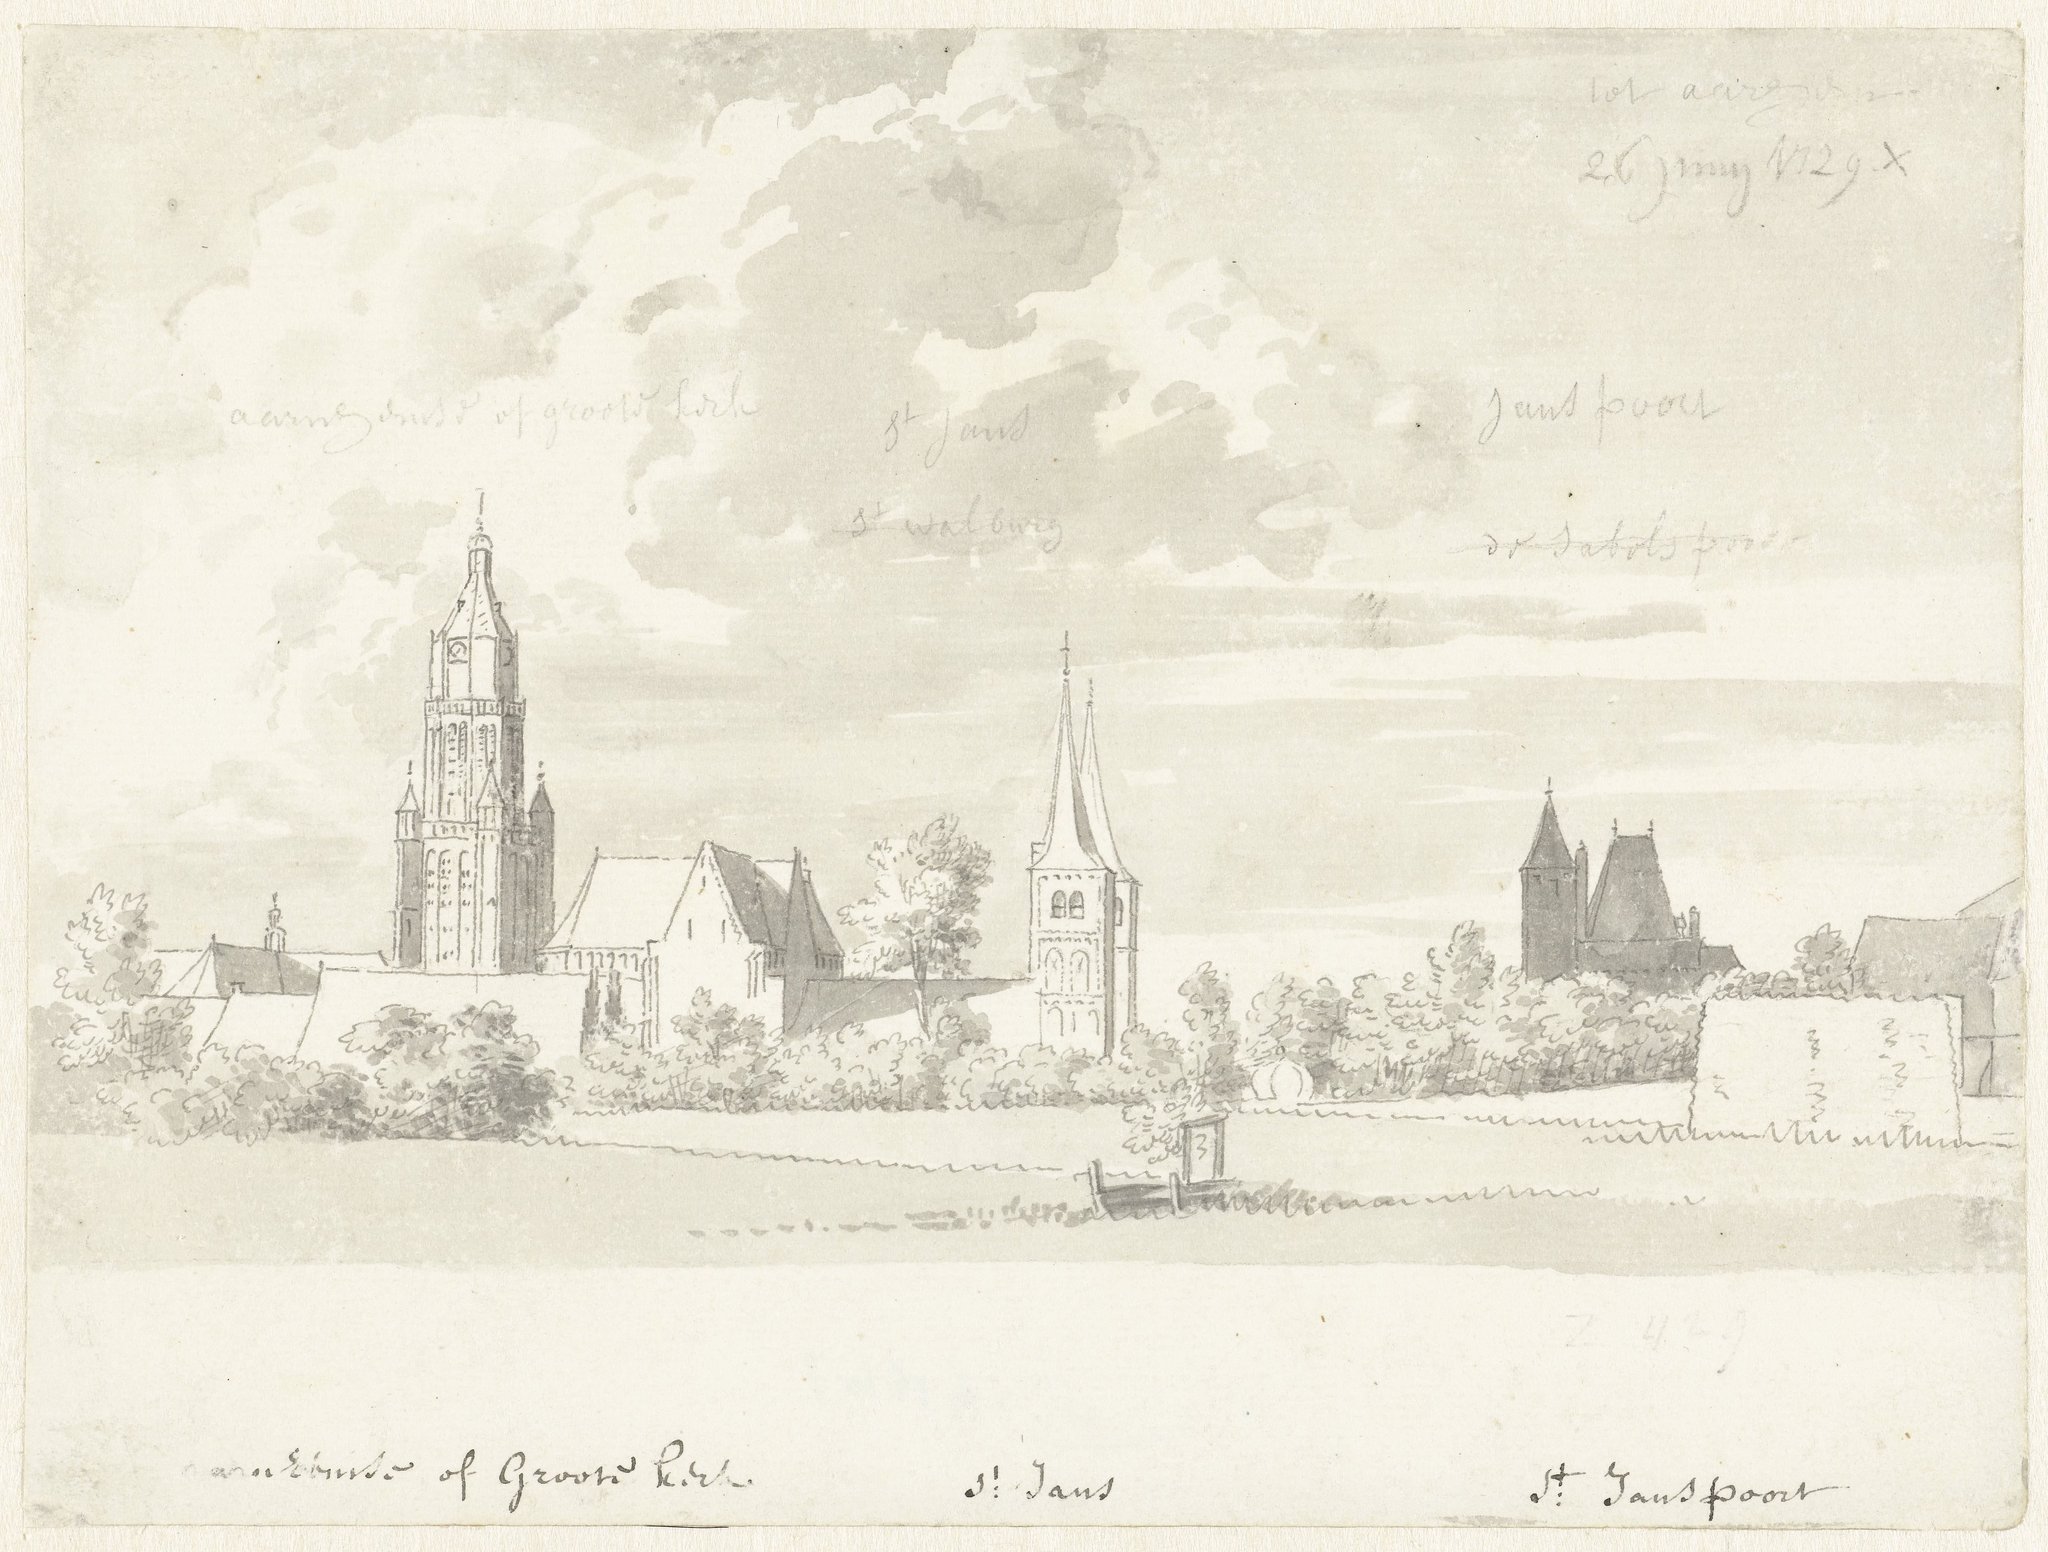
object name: drawing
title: Gezicht op Arnhem met de Eusebiuskerk, de St. Janskerk, de St. Walburgskerk en de St. Janspoort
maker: cornelis pronk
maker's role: draughtsman, painter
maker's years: 1691-1759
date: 1729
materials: ink, paper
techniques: brush, pen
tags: church (exterior), prospect of city, town panorama, silhouette of city, arnhem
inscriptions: inscription: ‘tot aarnhem / 26 juny 1729 X / aarnhems of groote kerk / st. jans / st. walburg / janspoort / de sabelspoort’